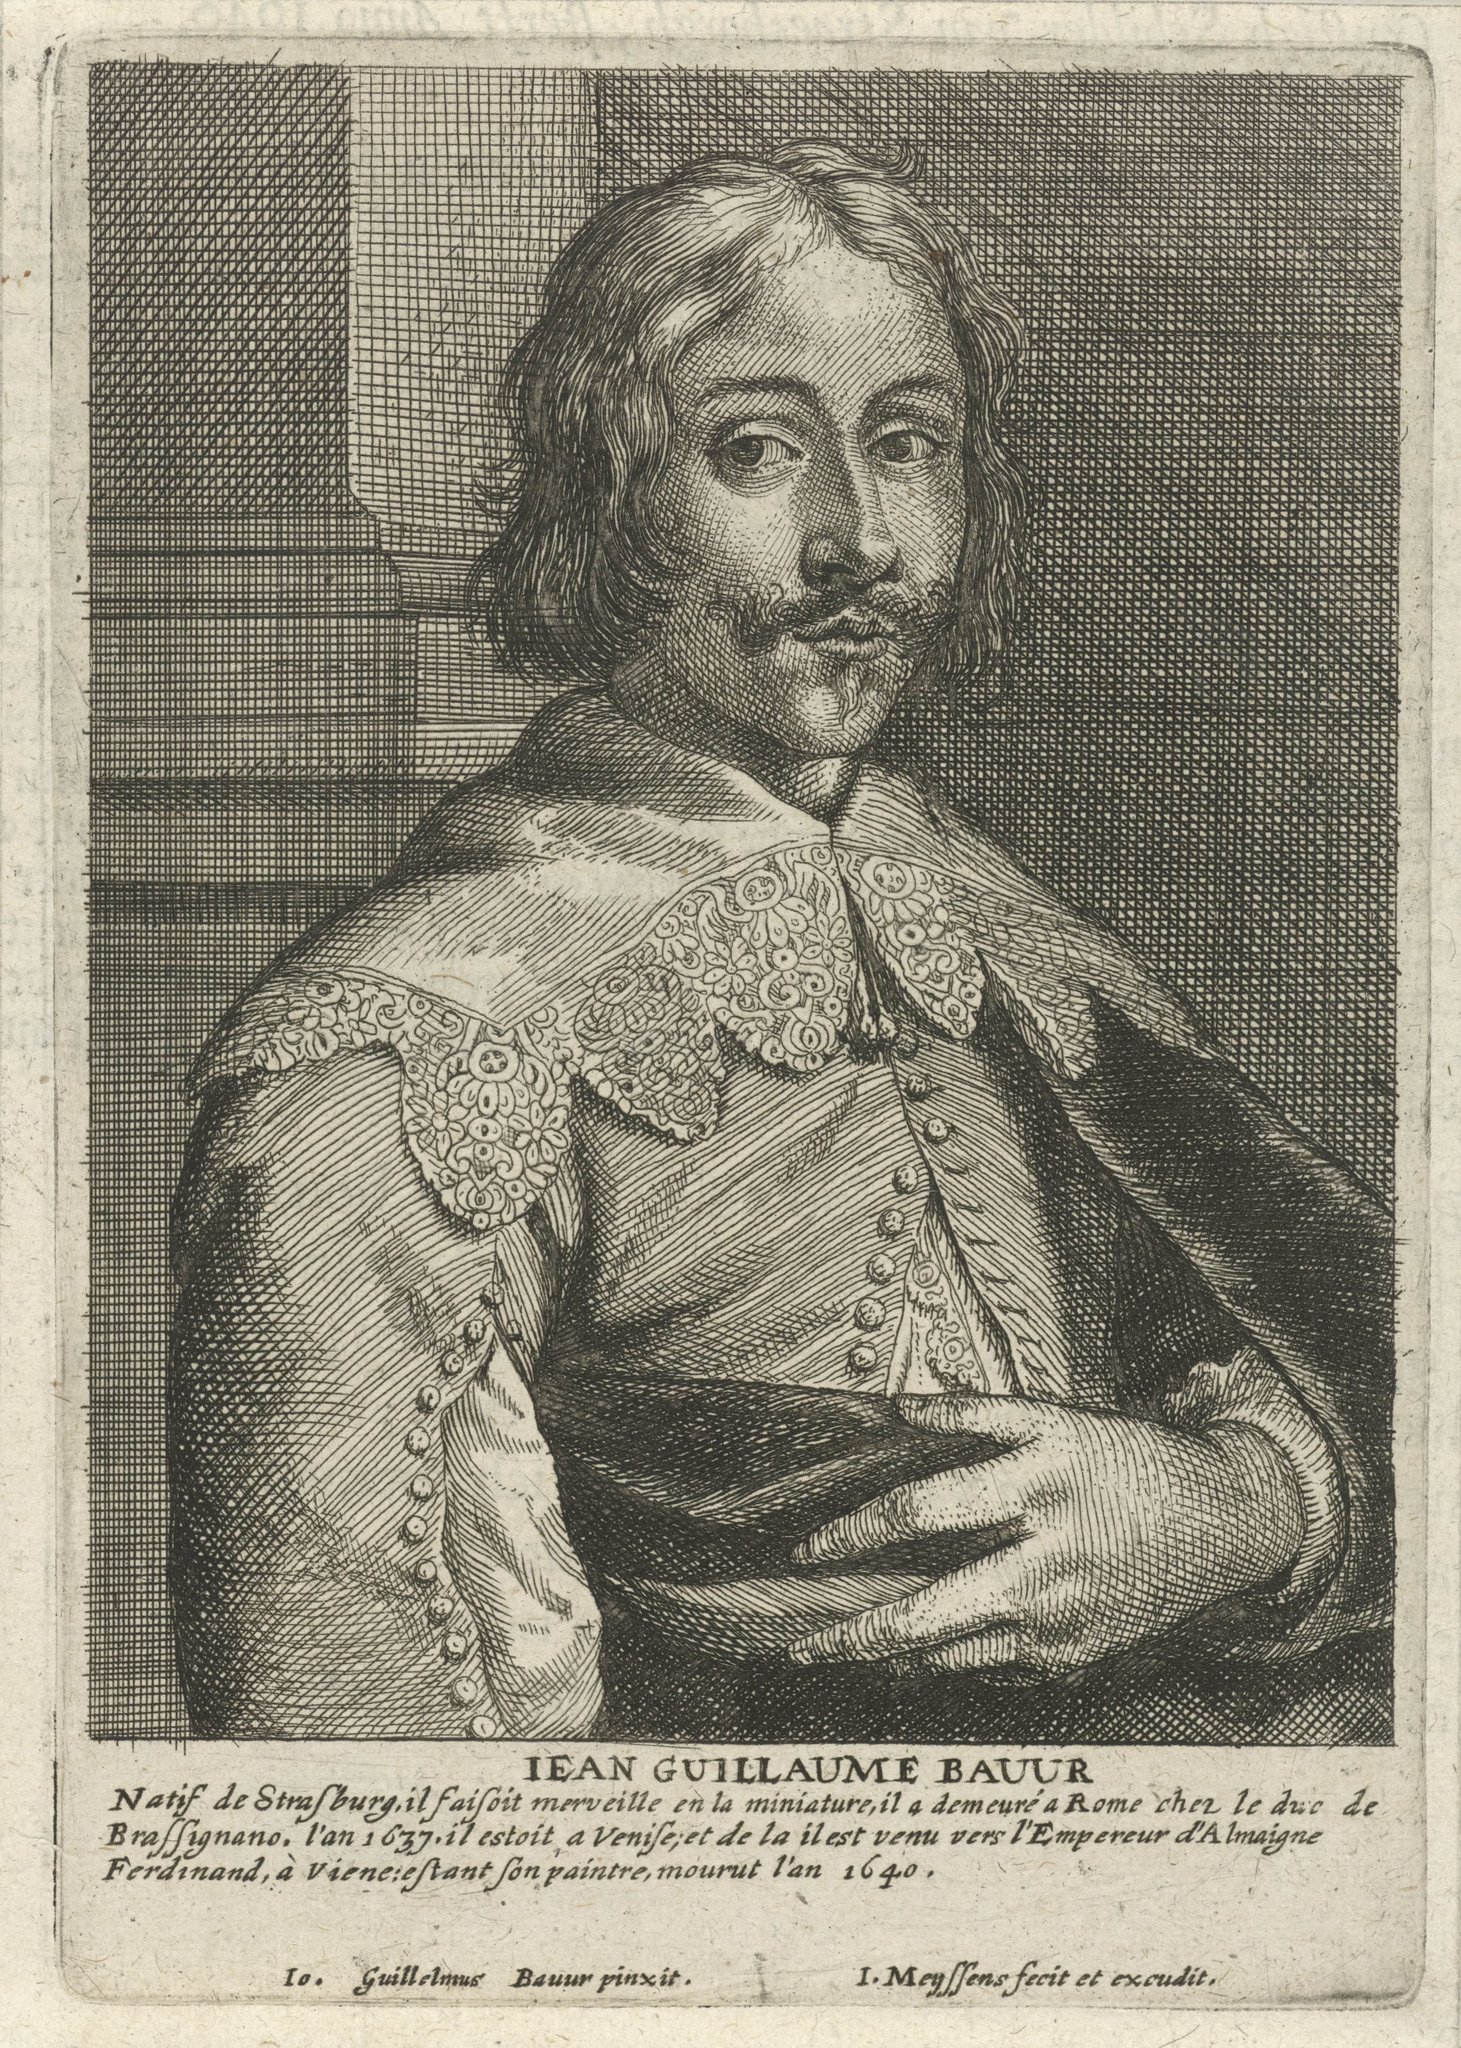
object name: book illustration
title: Portret van Johann Wilhelm Baur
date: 1662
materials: paper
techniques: engraving, etching, letterpress printing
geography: antwerp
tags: painter, print maker, draughtsman, johann wilhelm baur, portrait, self-portrait of artist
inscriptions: collector's mark: Lugt 2228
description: Prent uit: Bie, Cornelis de. Het gulden cabinet vande edele vry schilder-const. 3 dln. Antwerpen: Joannes Meyssens en Juliaen van Montfort, 1662, dl. 1, p. 113.